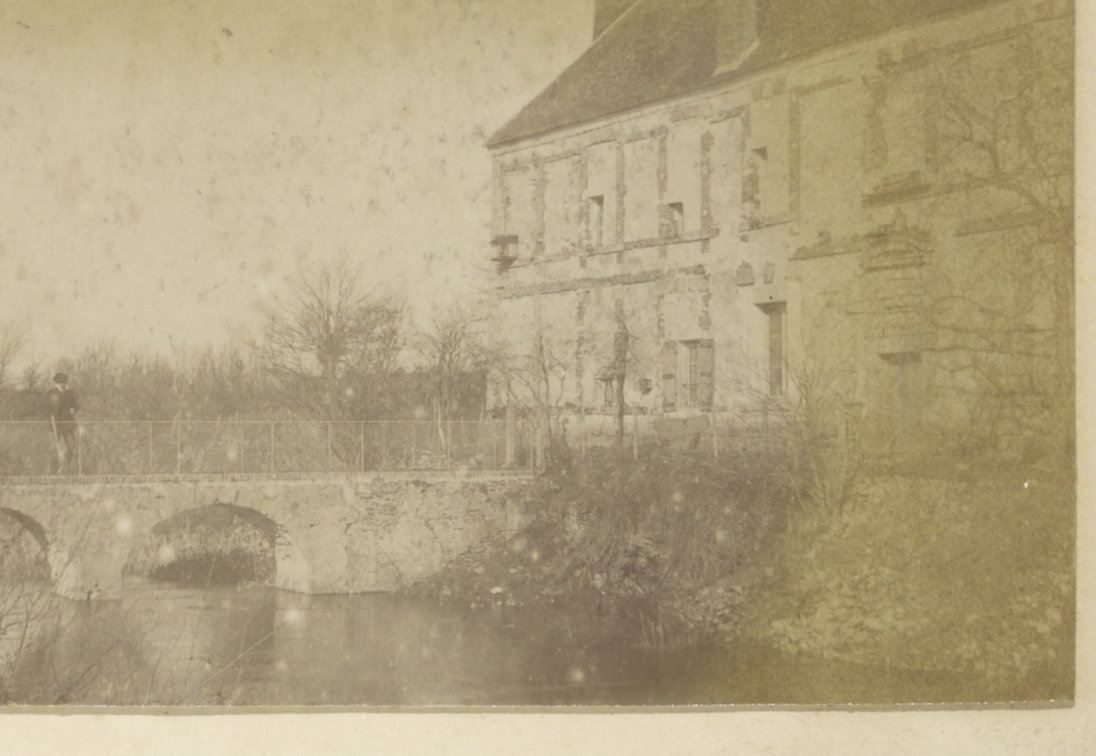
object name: photograph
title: Landhuis met brug, gracht en dichtgemetselde ramen in Frankrijk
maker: Anonymous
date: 1900-1910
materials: paper, photographic support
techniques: albumen print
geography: france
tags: canal, rural housing, e.g. country-house, villa, cottage, façade (of house or building), bridge, france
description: Onderdeel van Fotoalbum van een Franse amateurfotograaf met opnames van een familie, distilleerderij Delizy & Doistau Fils, het leger en bezienswaardigheden in Frankrijk.